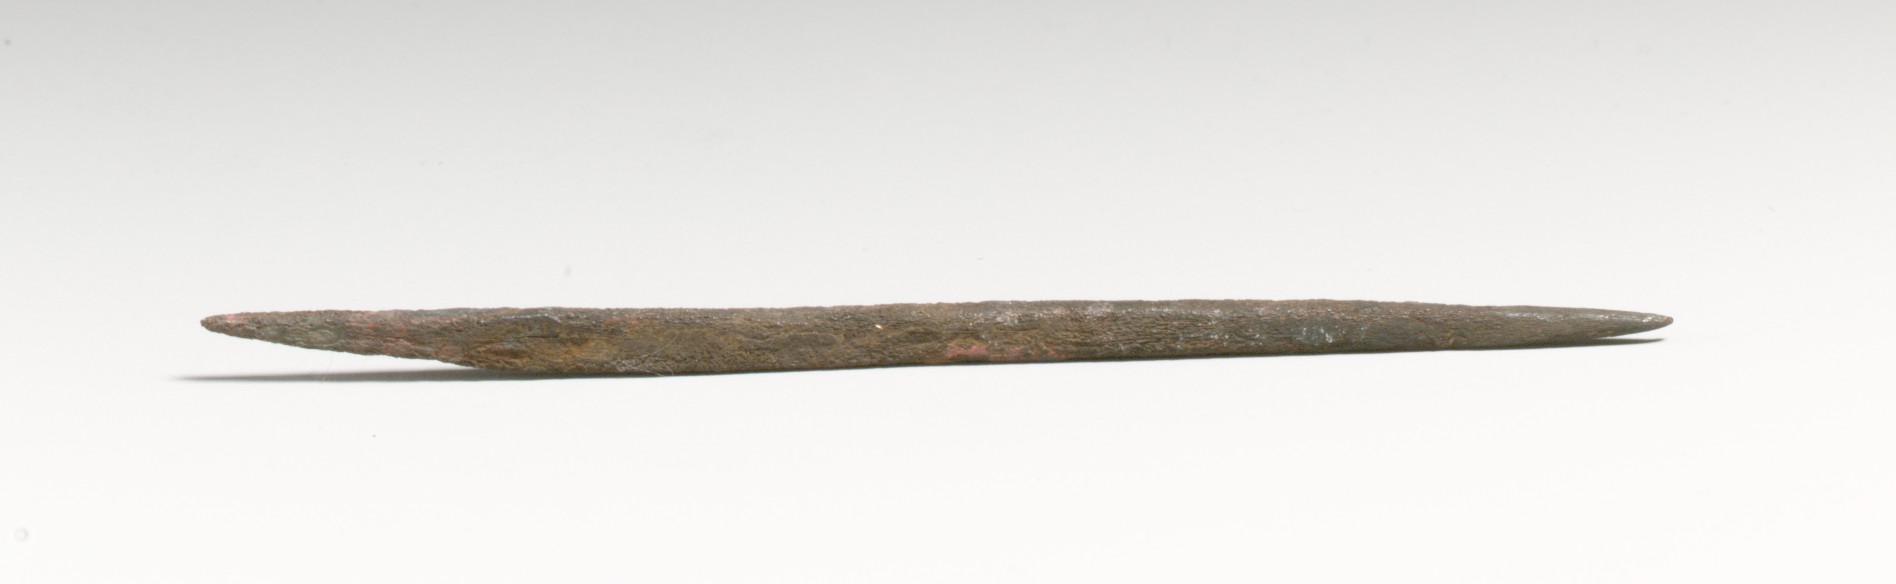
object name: awl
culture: cypriot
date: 3900 BCE-100 CE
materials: bronze